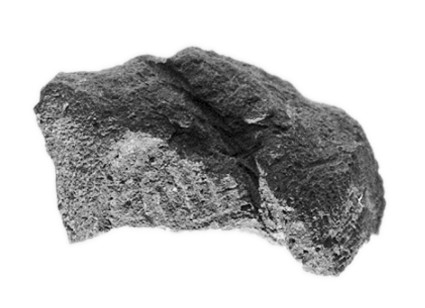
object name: sealing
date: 1981-1640 BCE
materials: mud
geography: egypt